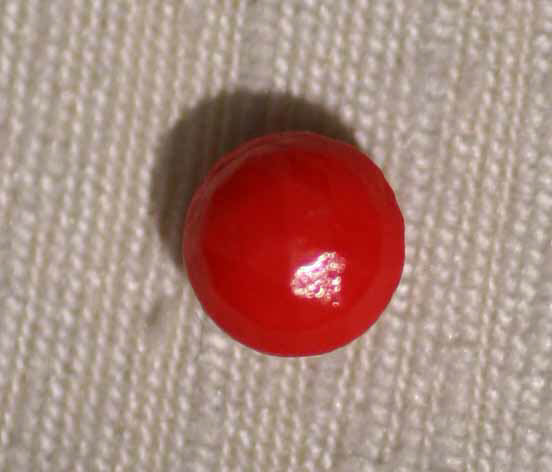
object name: bead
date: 701-1000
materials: glass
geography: iran